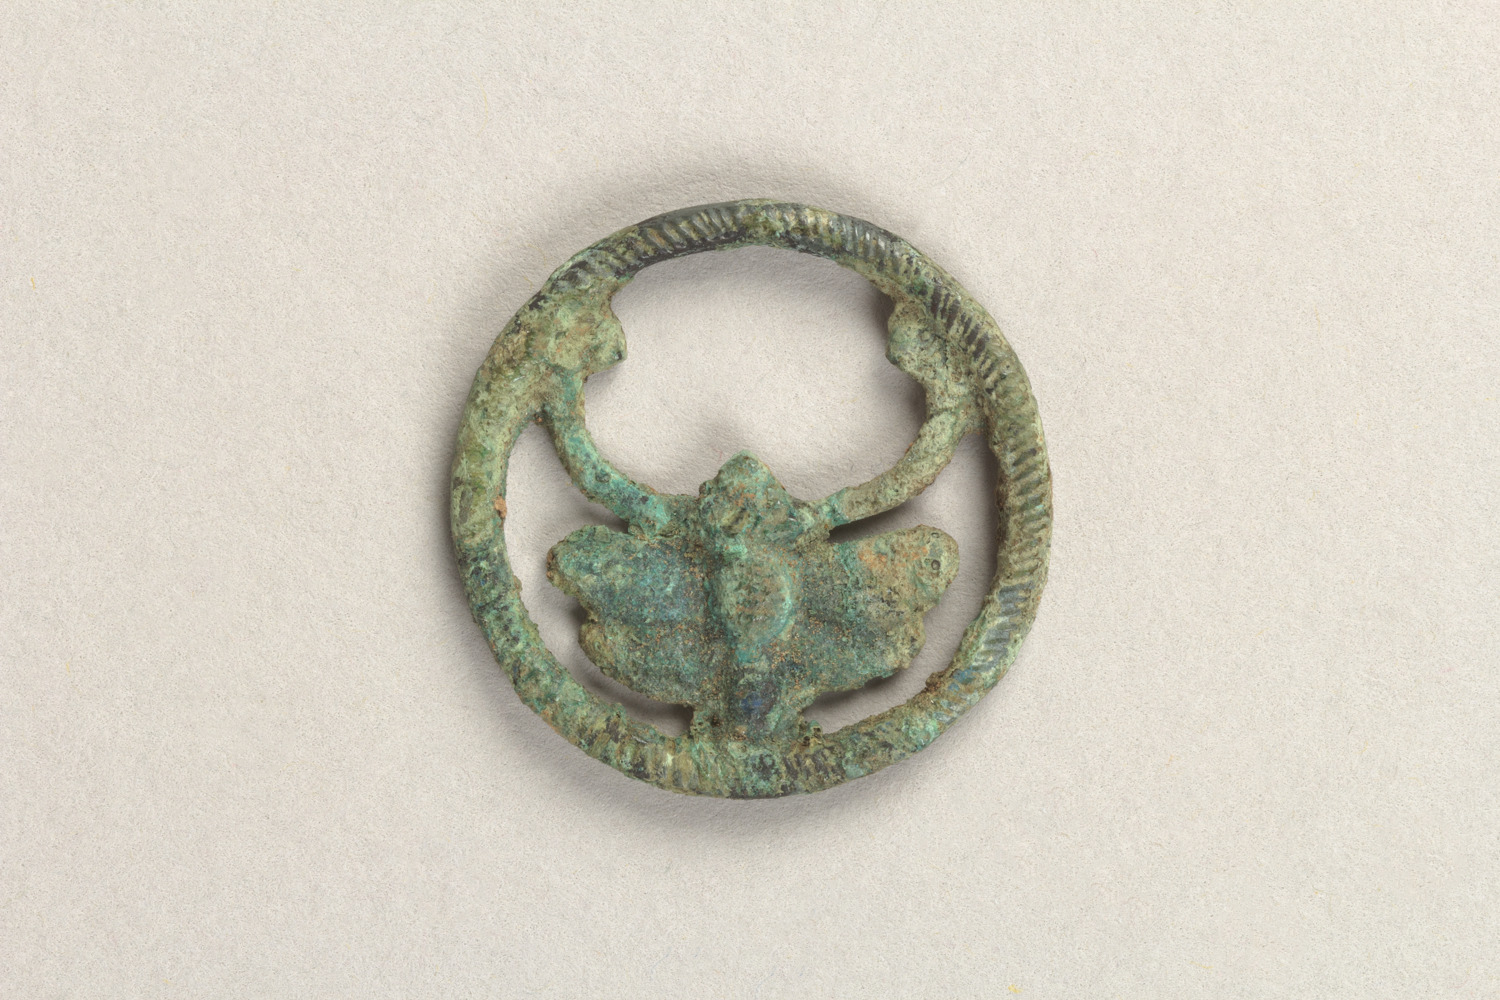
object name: ornament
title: Ornament with insect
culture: korean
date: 918-1392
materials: bronze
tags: insects